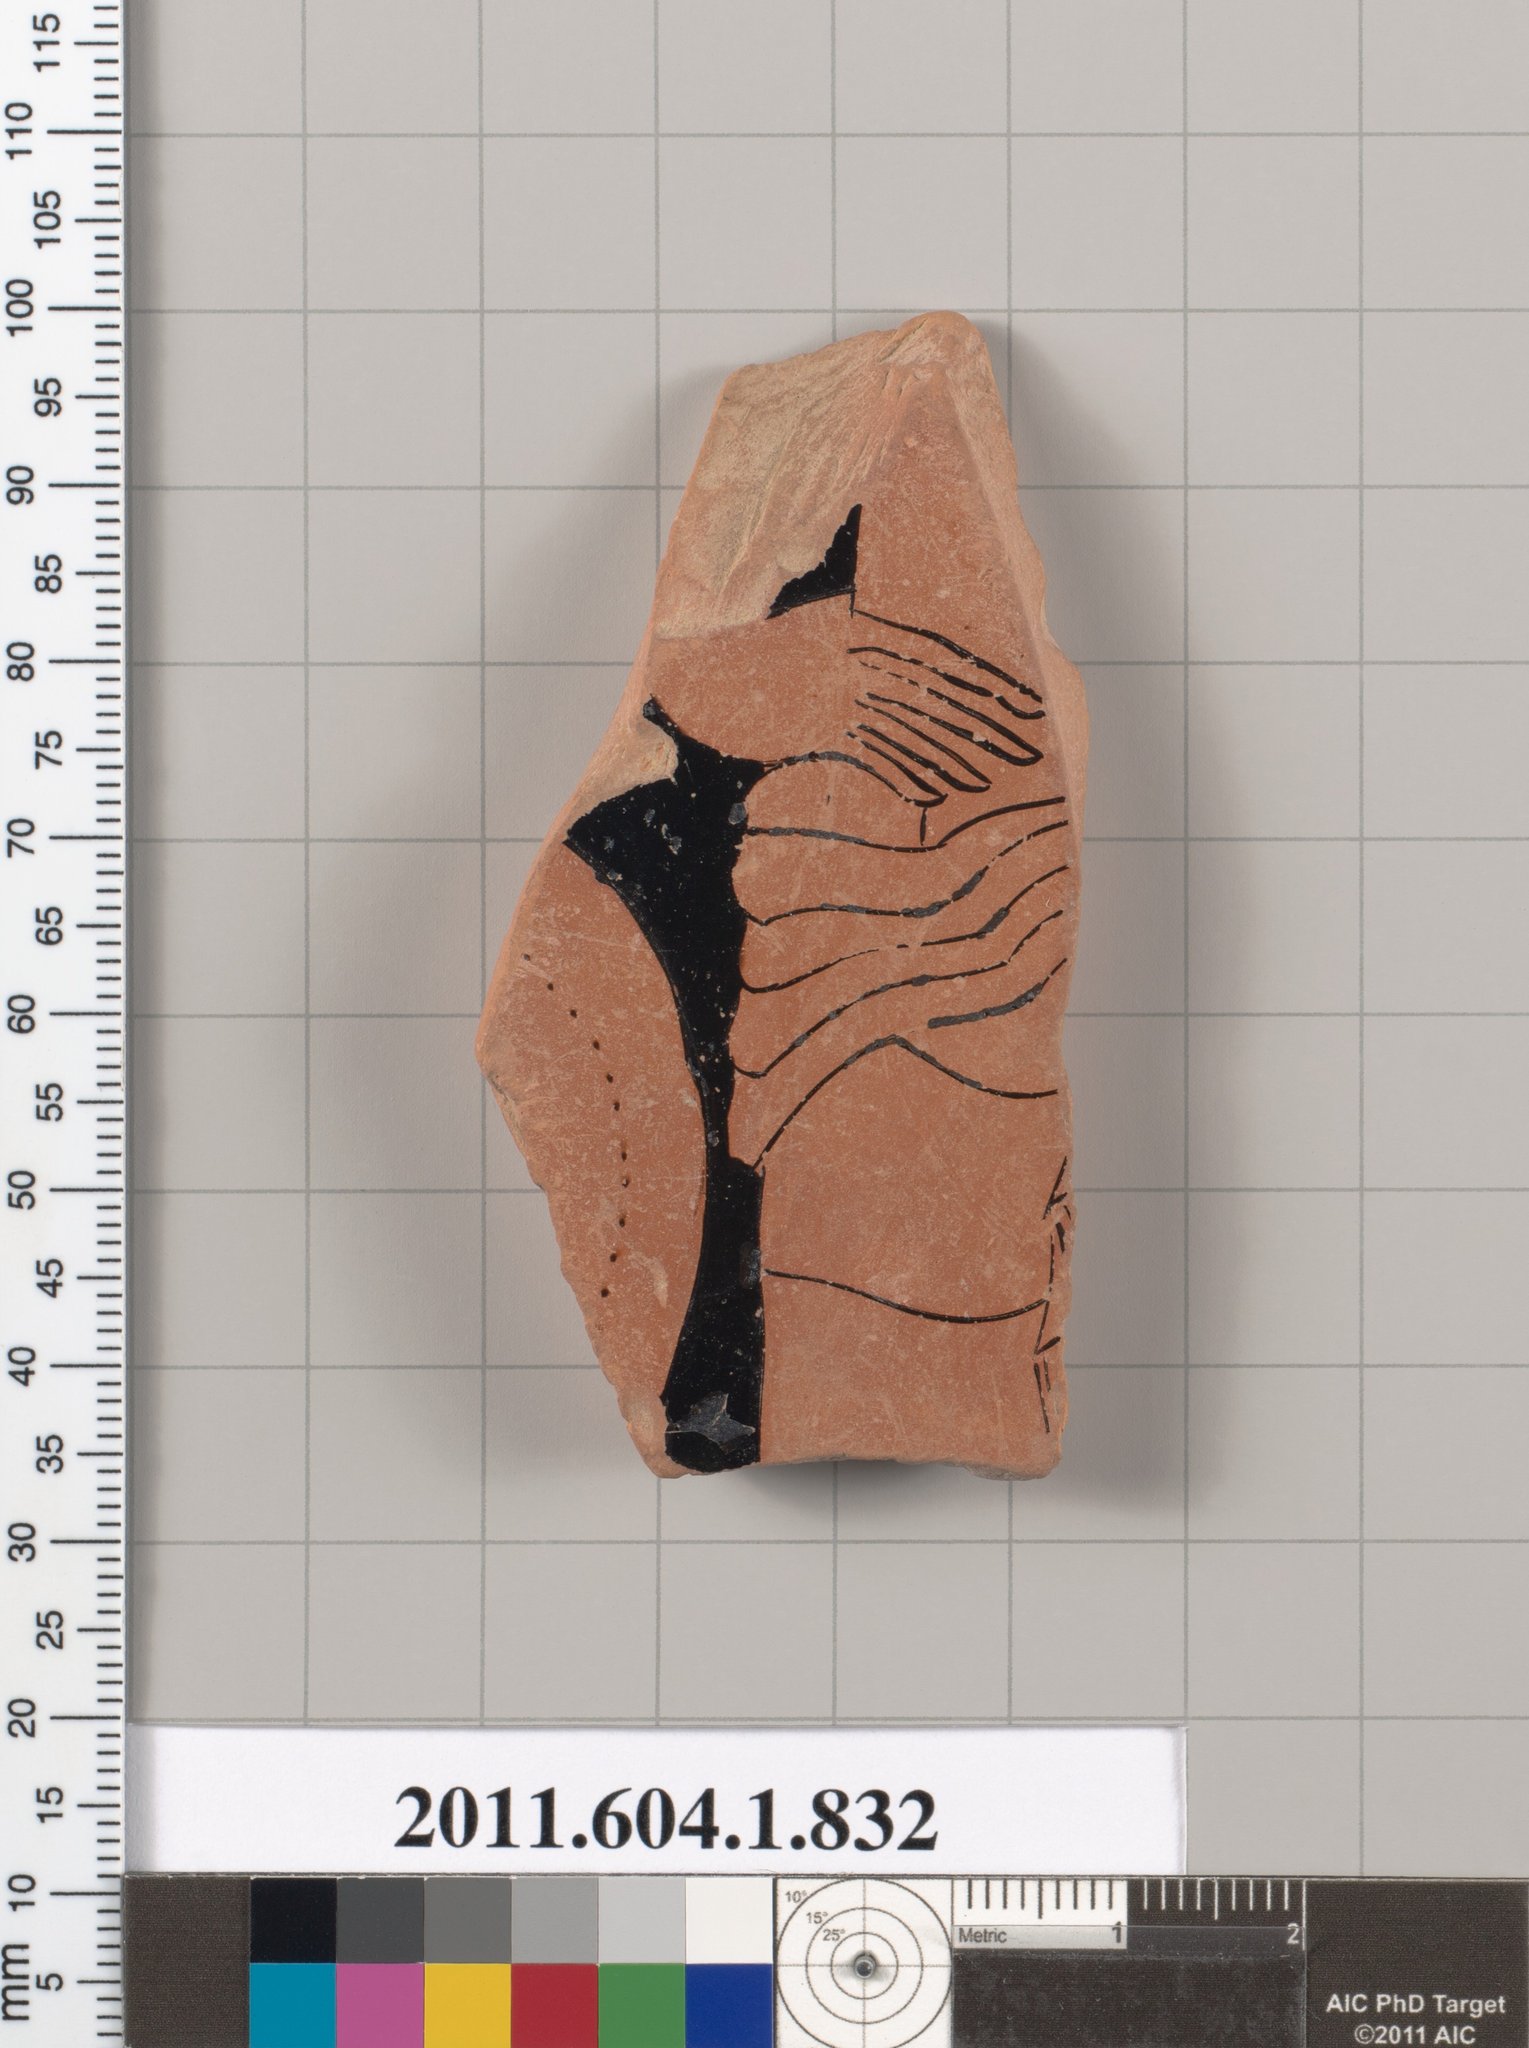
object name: kylix fragment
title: Terracotta fragment of a kylix (drinking cup)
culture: greek, attic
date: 475-451 BCE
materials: terracotta